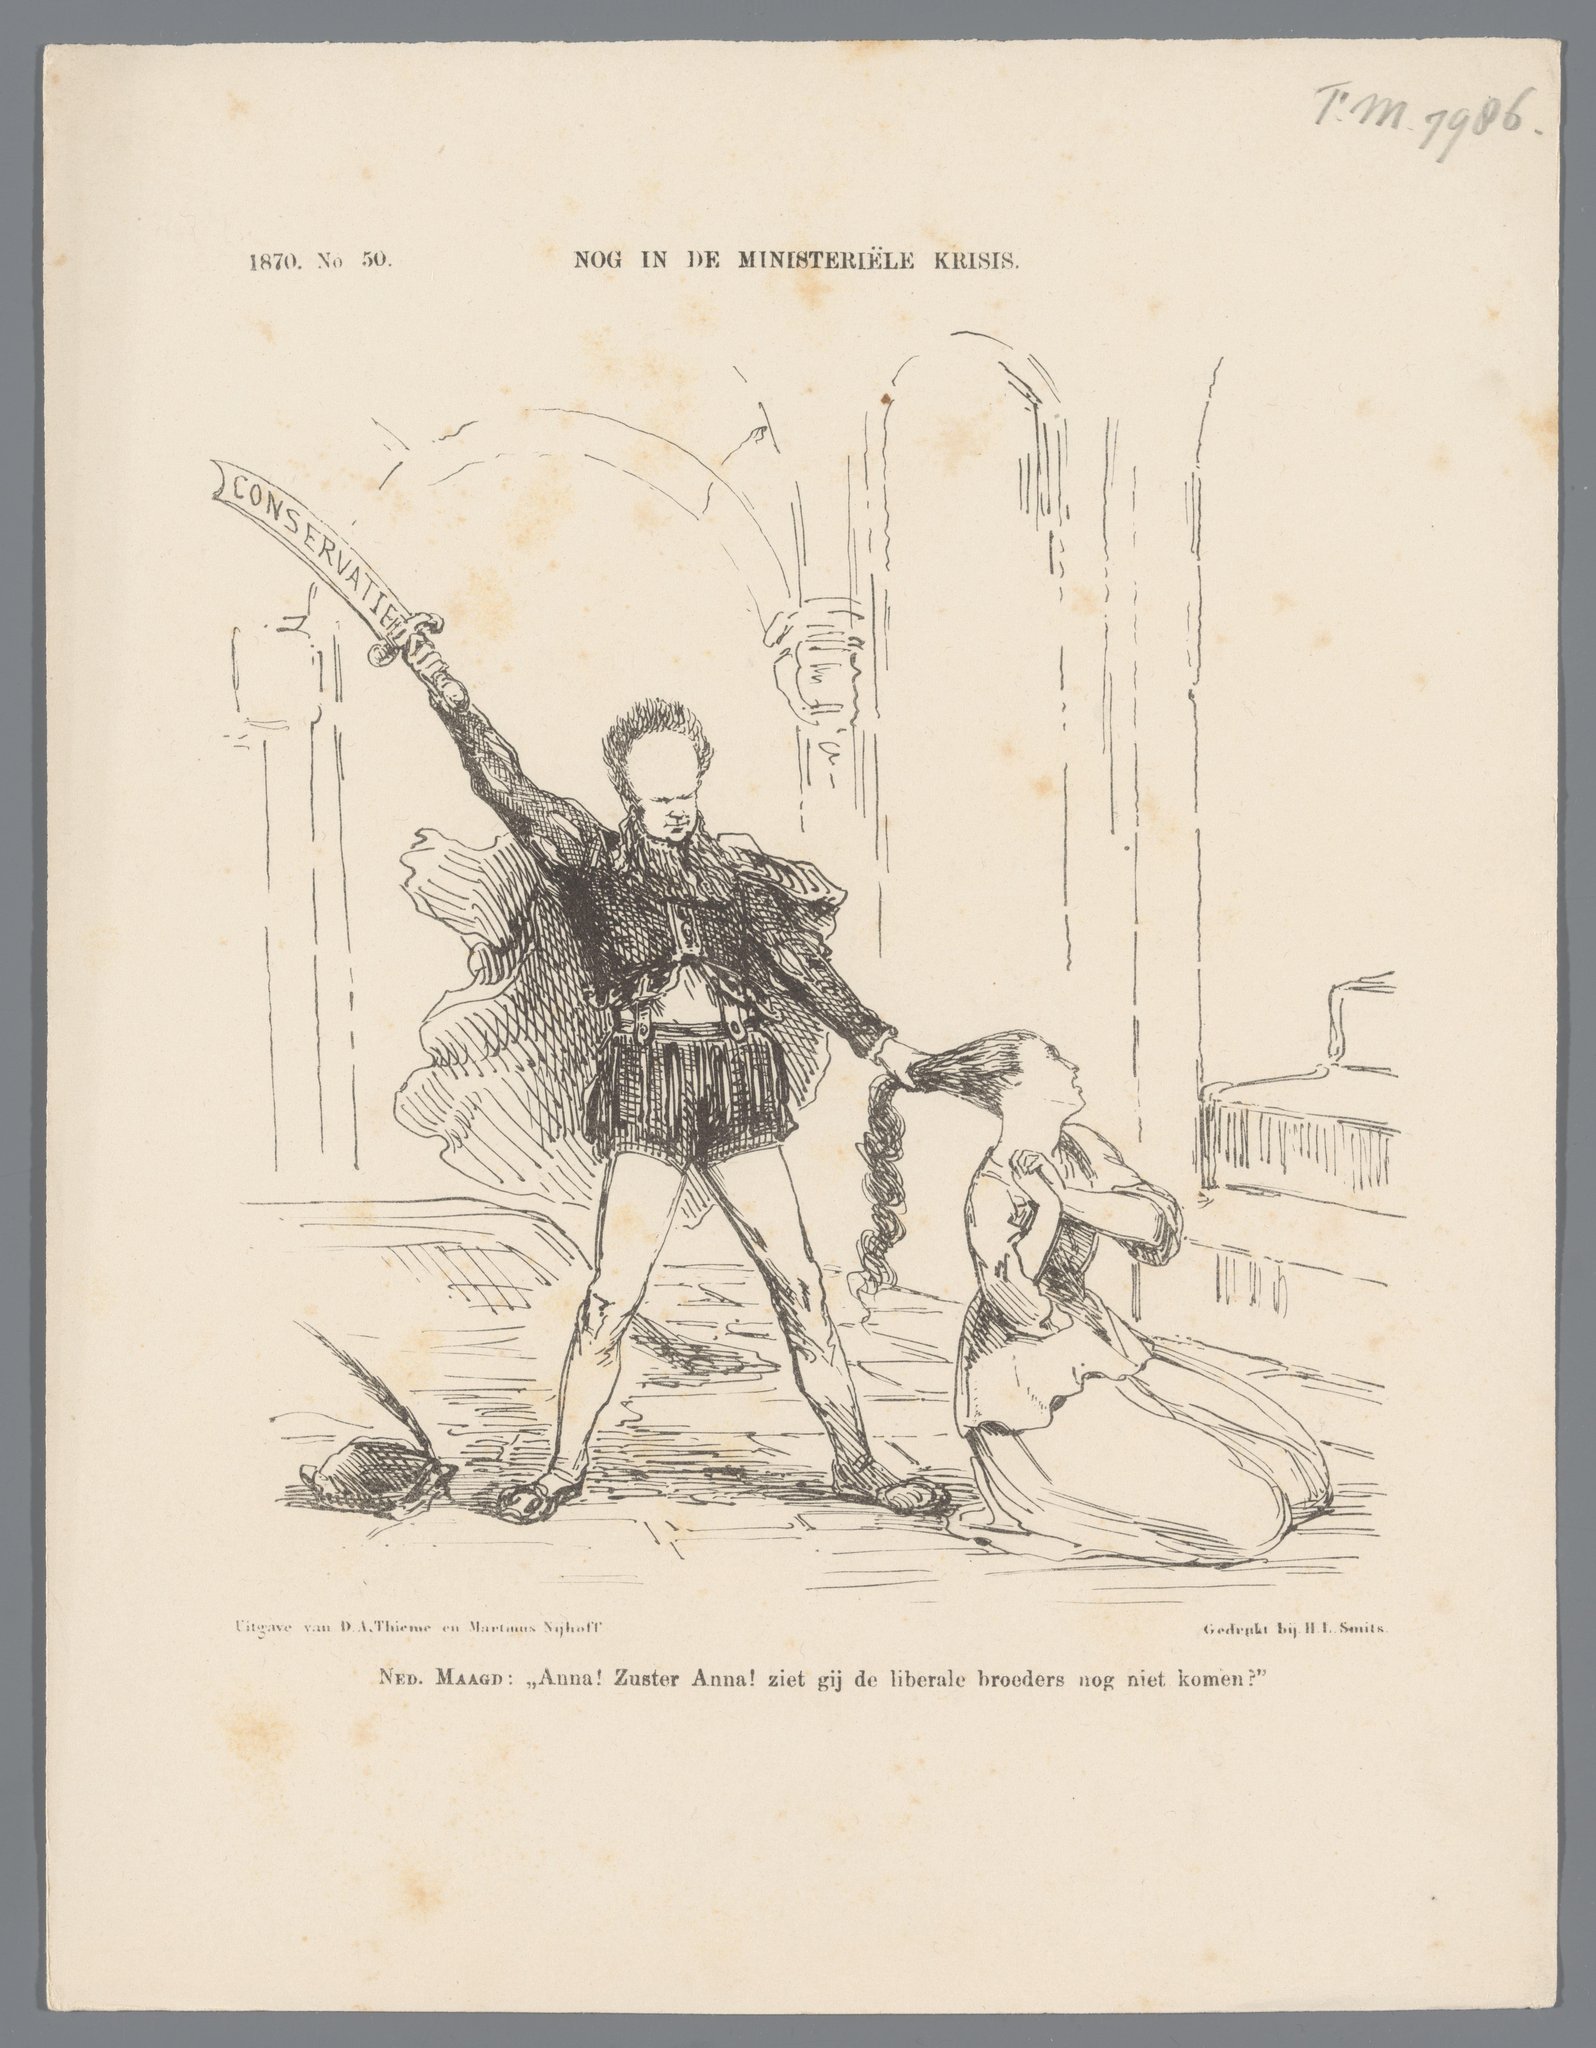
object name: cartoon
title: Spotprent op de ministeriële krisis, 1870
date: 1870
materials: paper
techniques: lithograph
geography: arnhem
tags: amsterdam, the hague, politician, personifications of countries, nations, states, districts, etc., tales and fairy tales (with title)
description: Spotprent op de langdurige ministeriële krisis. Blauwbaard (Heemskerk) dreigt zijn vrouw (Nederlandse Maagd) met het zwaard het hoofd af te slaan. Zij roept 'Anna! Zuster Anna! ziet gij ... nog niet komen?' Plaat verschenen bij het weekblad De Nederlandsche Spectator, nr. 50, 1870.